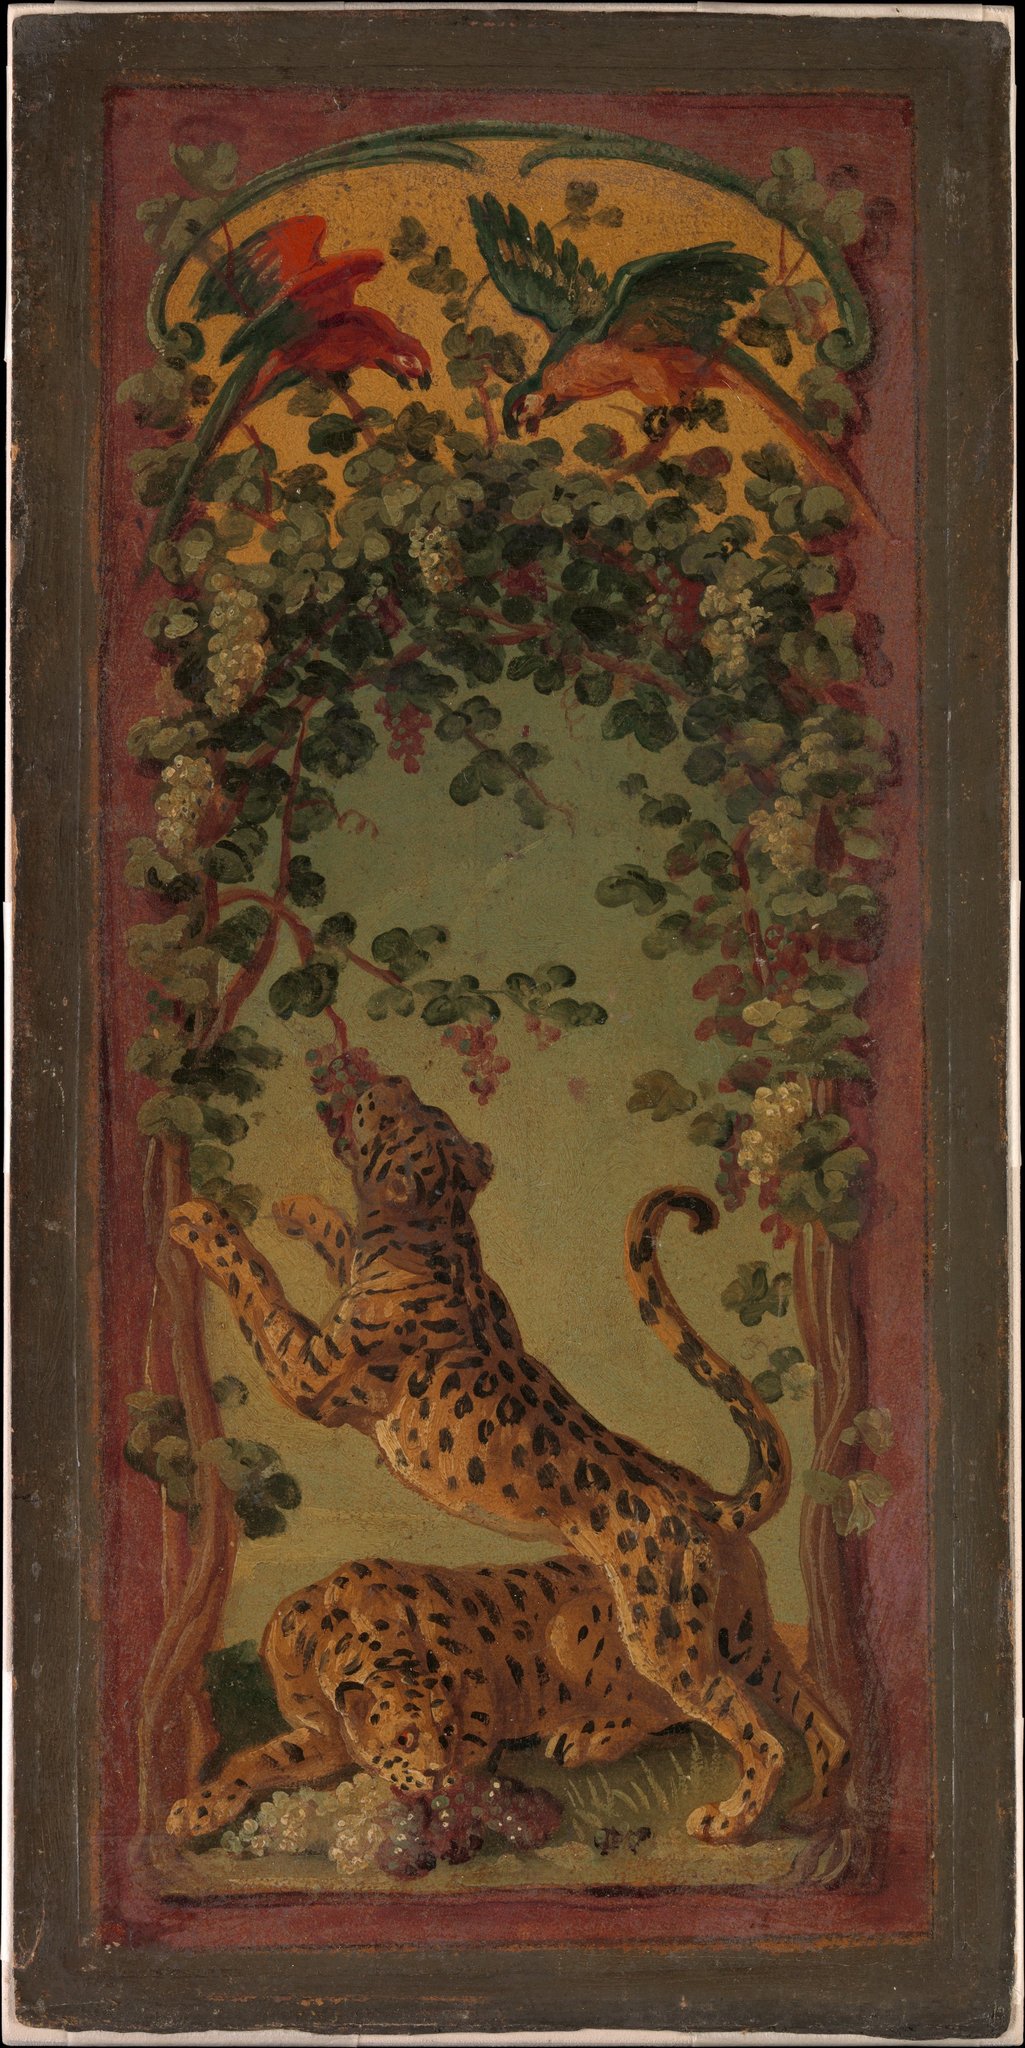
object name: painting, drawing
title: Panthers of Bacchus Eating Grapes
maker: alexandre françois desportes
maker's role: artist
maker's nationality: french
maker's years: 1661-1743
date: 1719-1720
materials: oil, paper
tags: birds,grapes,vines,panthers